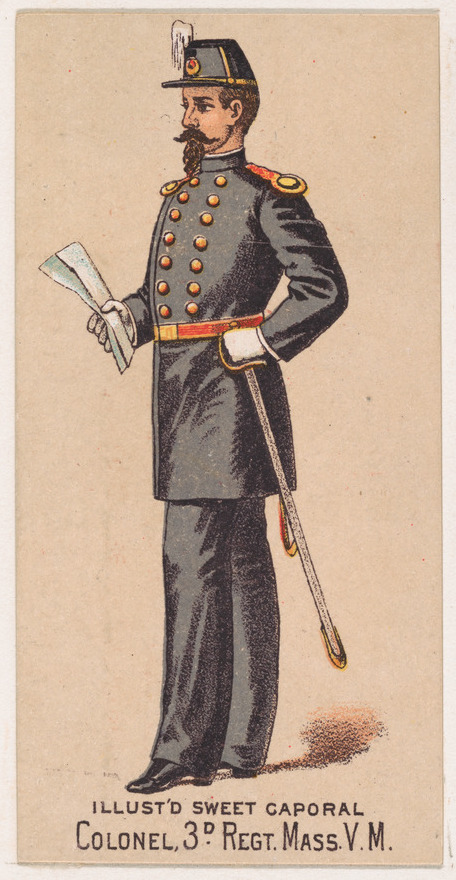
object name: print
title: Colonel, 3rd Regiment, Massachusetts, V.M., from the Military Series (N224) issued by Kinney Tobacco Company to promote Sweet Caporal Cigarettes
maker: kinney brothers tobacco company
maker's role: publisher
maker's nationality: american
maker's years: 1869-2011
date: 1888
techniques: color lithograph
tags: military,swords,men,profiles